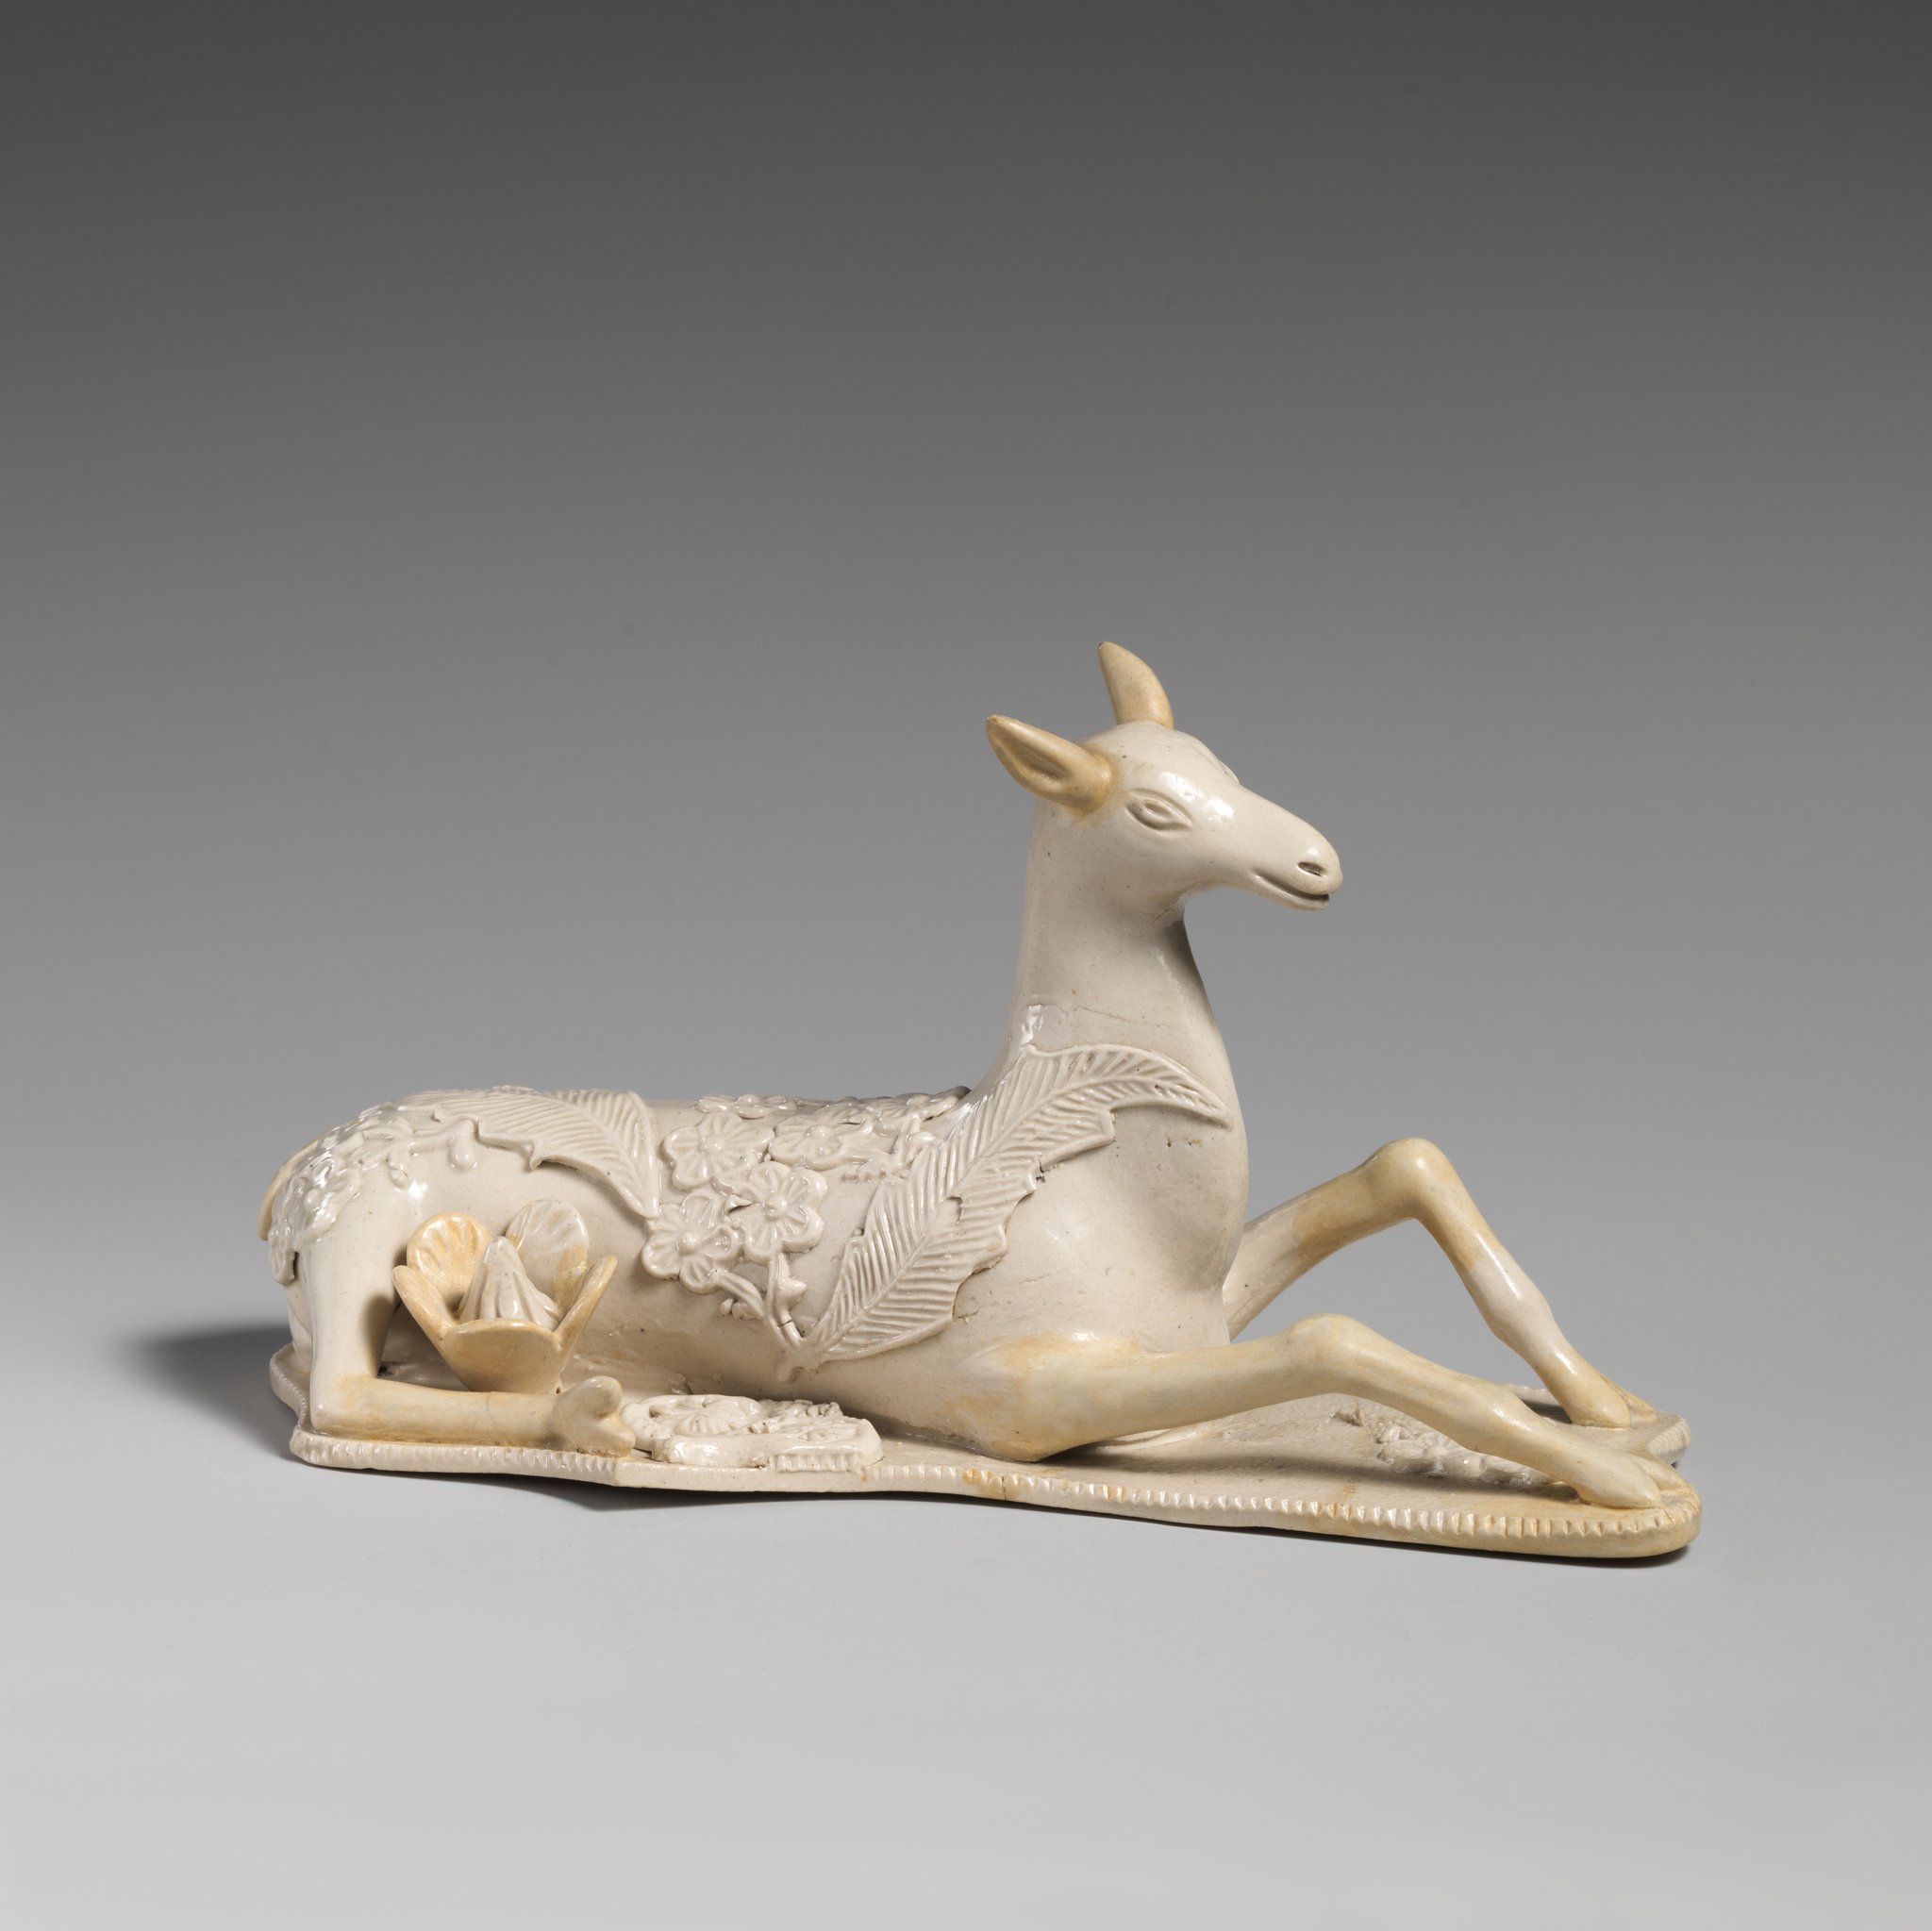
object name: figure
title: Doe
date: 1750-1755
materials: stoneware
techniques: salt glaze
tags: animals